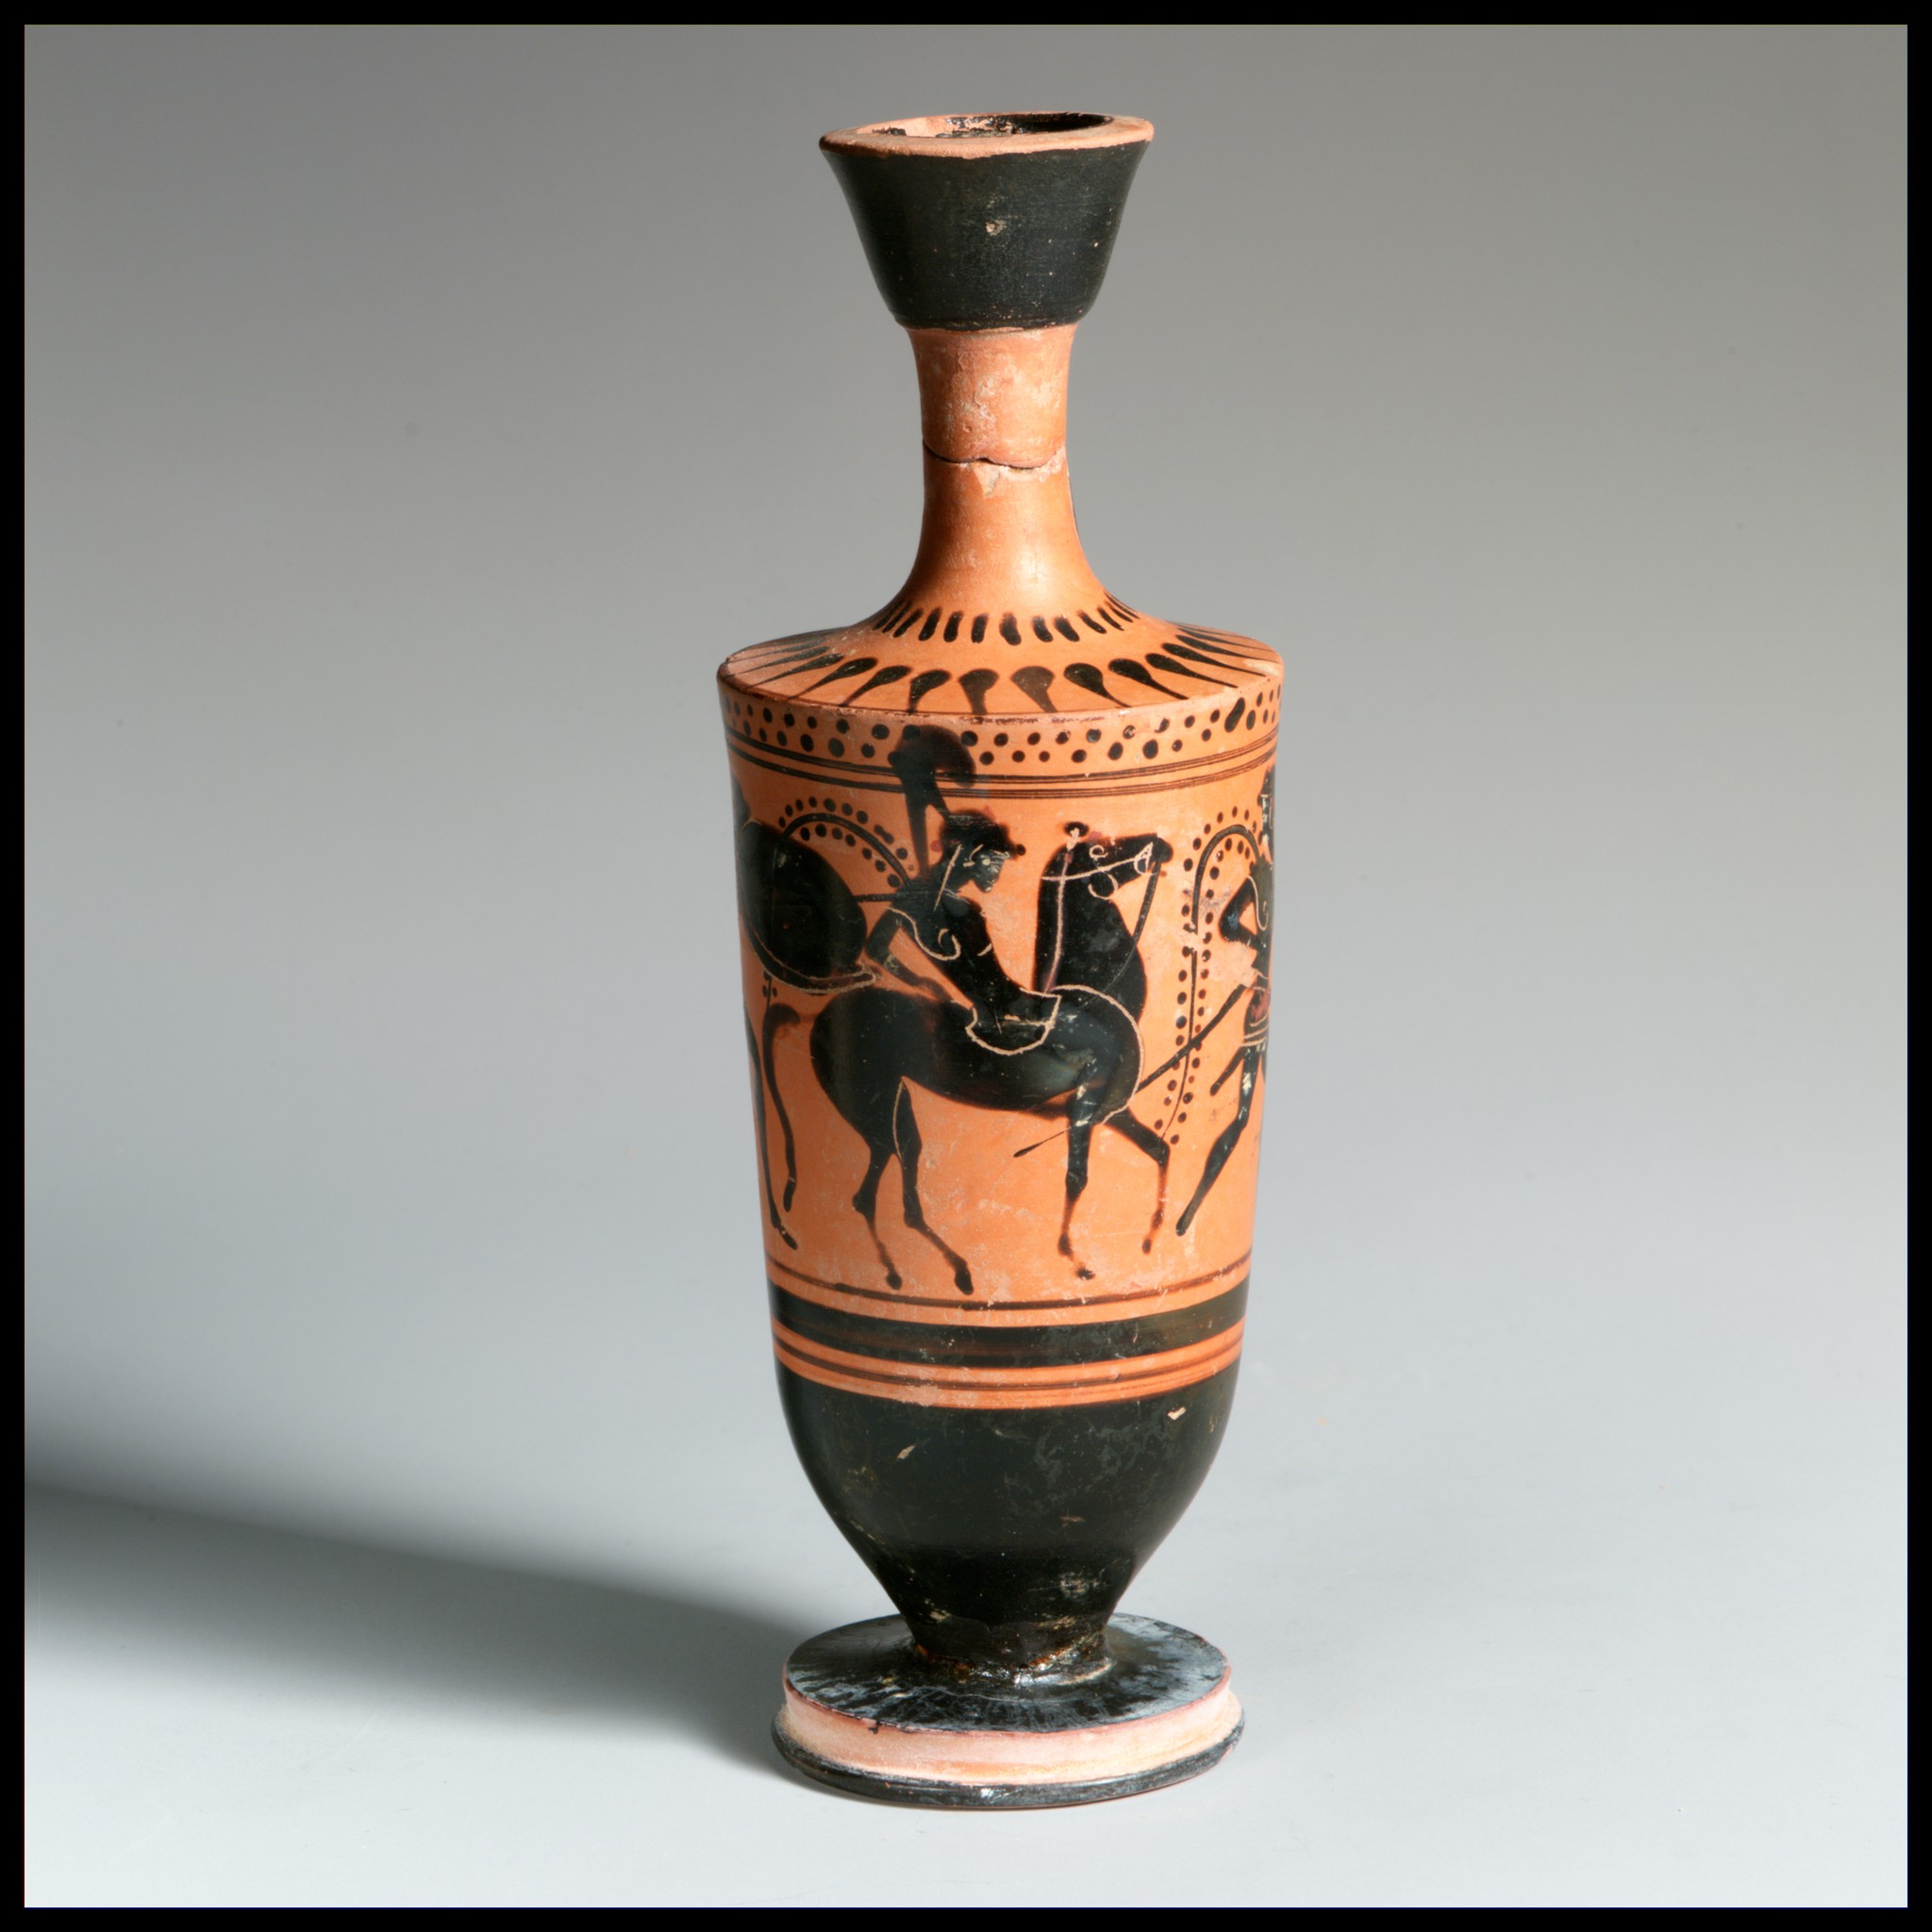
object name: lekythos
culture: greek, attic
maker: diosphos painter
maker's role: artist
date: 500-451 BCE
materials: terracotta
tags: amazons,horses